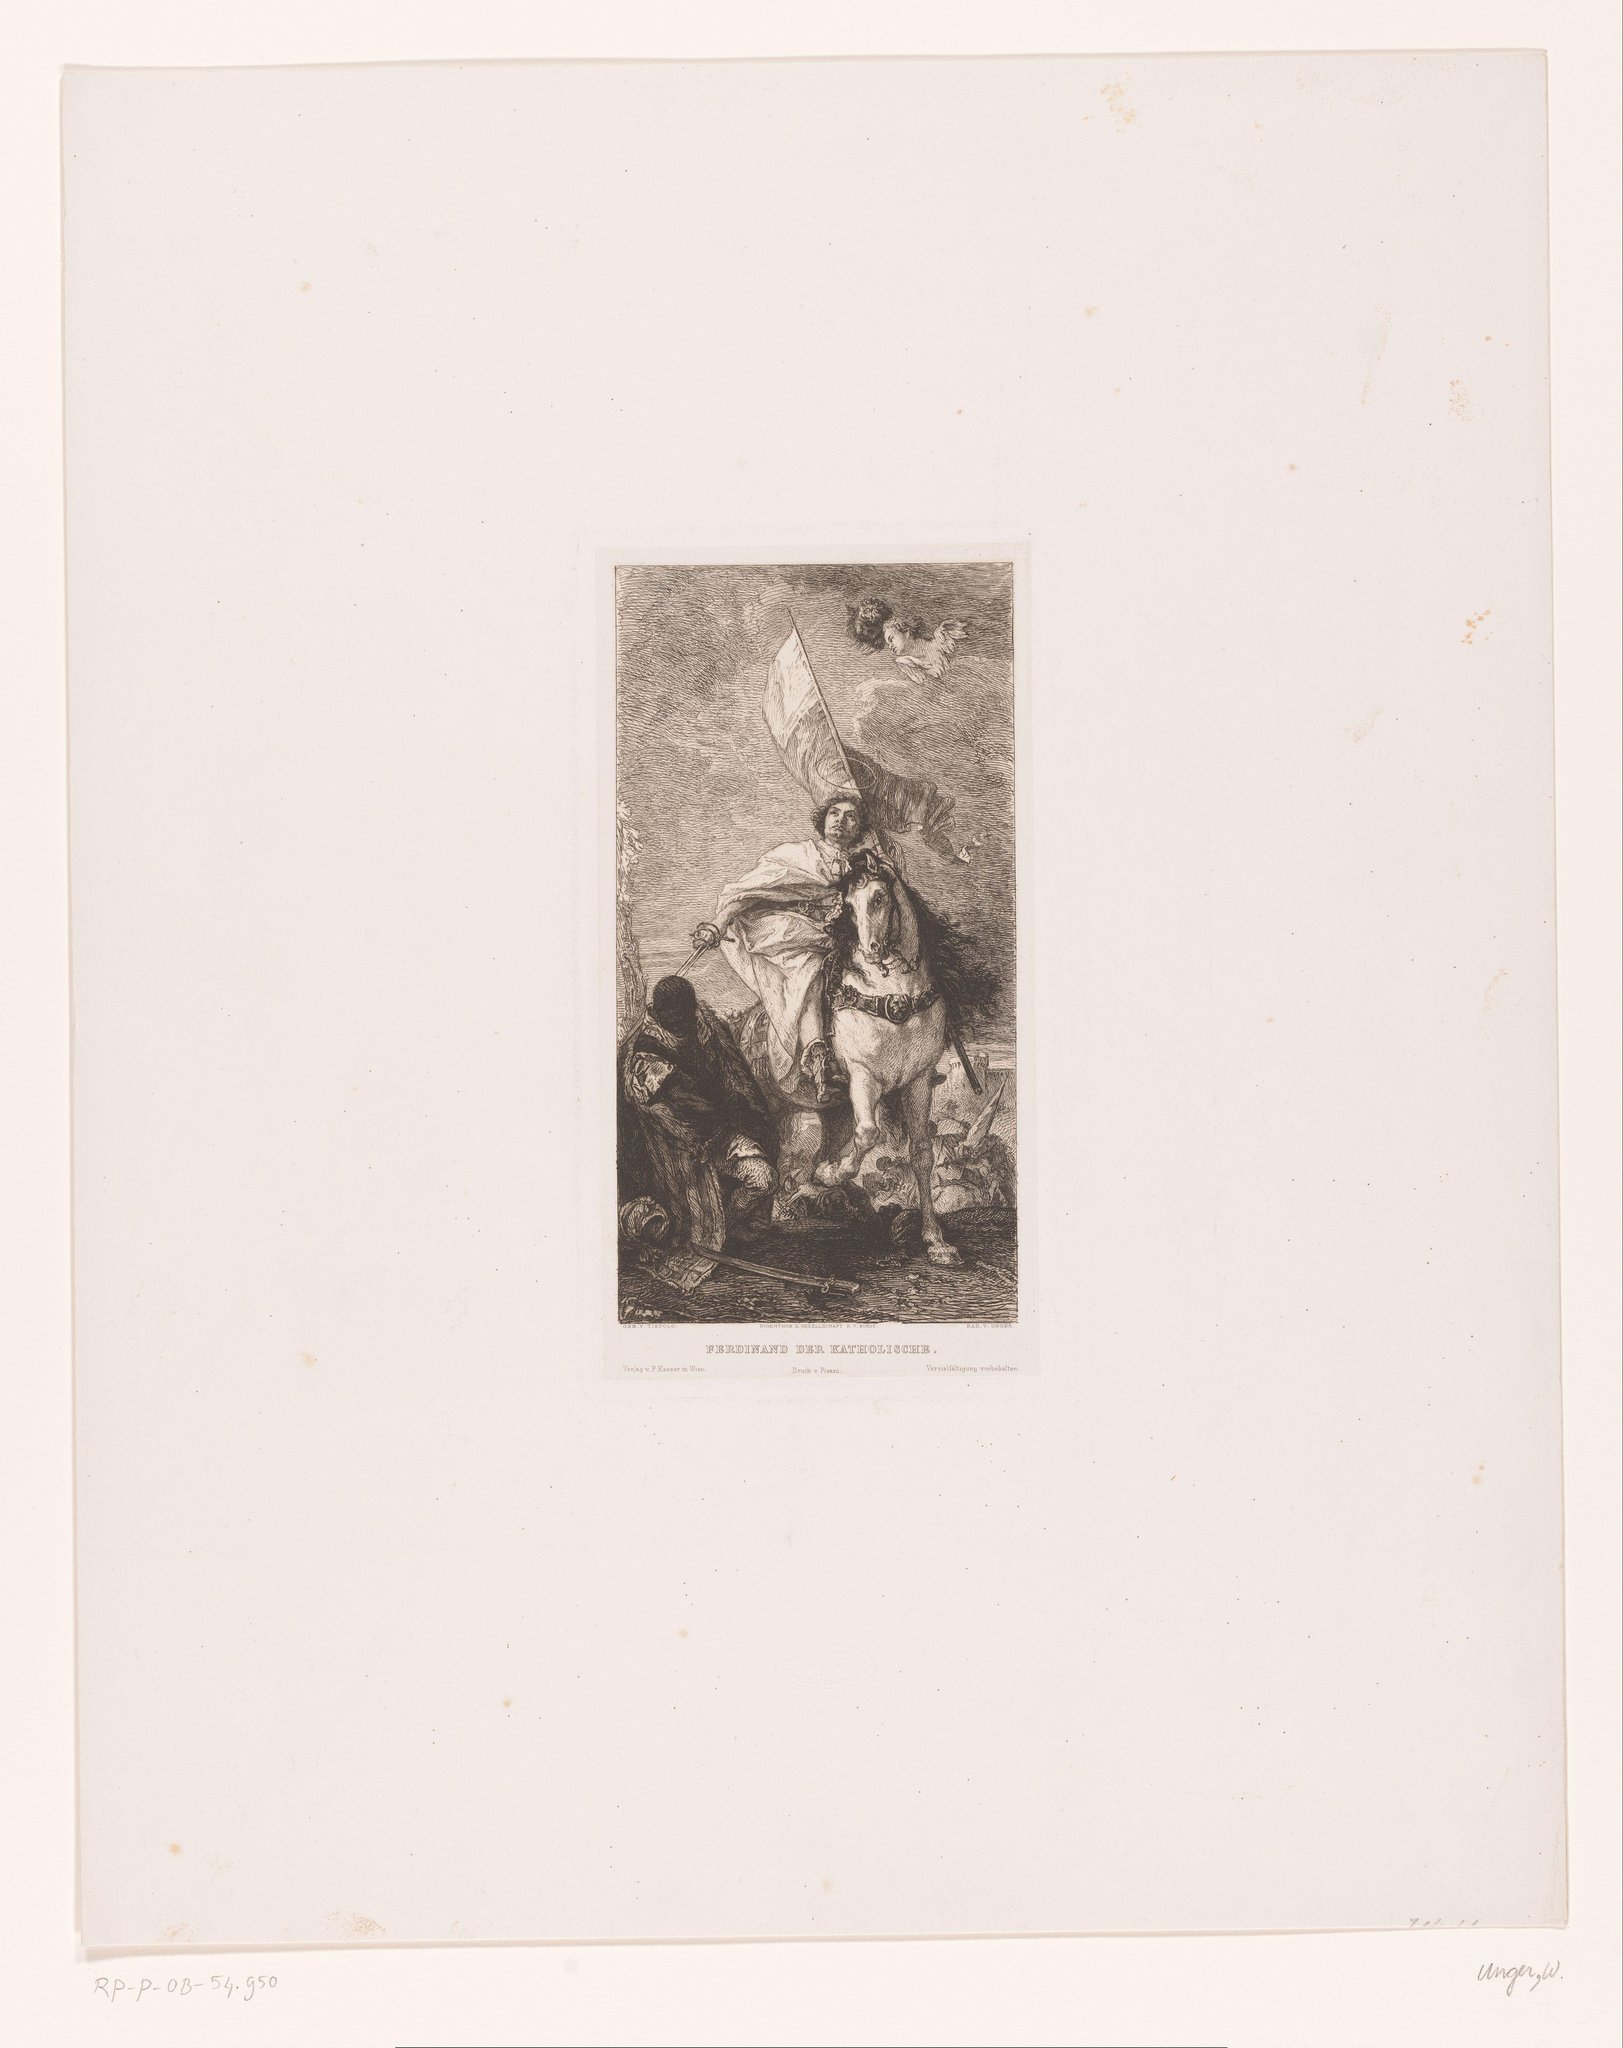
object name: print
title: Ferdinand der Katholische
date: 1847-1877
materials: paper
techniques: etching, intaglio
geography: vienna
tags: riding a horse, ass, or mule; rider, horseman, cherubs, i.e. children's heads with wings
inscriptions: check stamp: ‘Gesellschaft für vervielfalt. Kunst Wien’